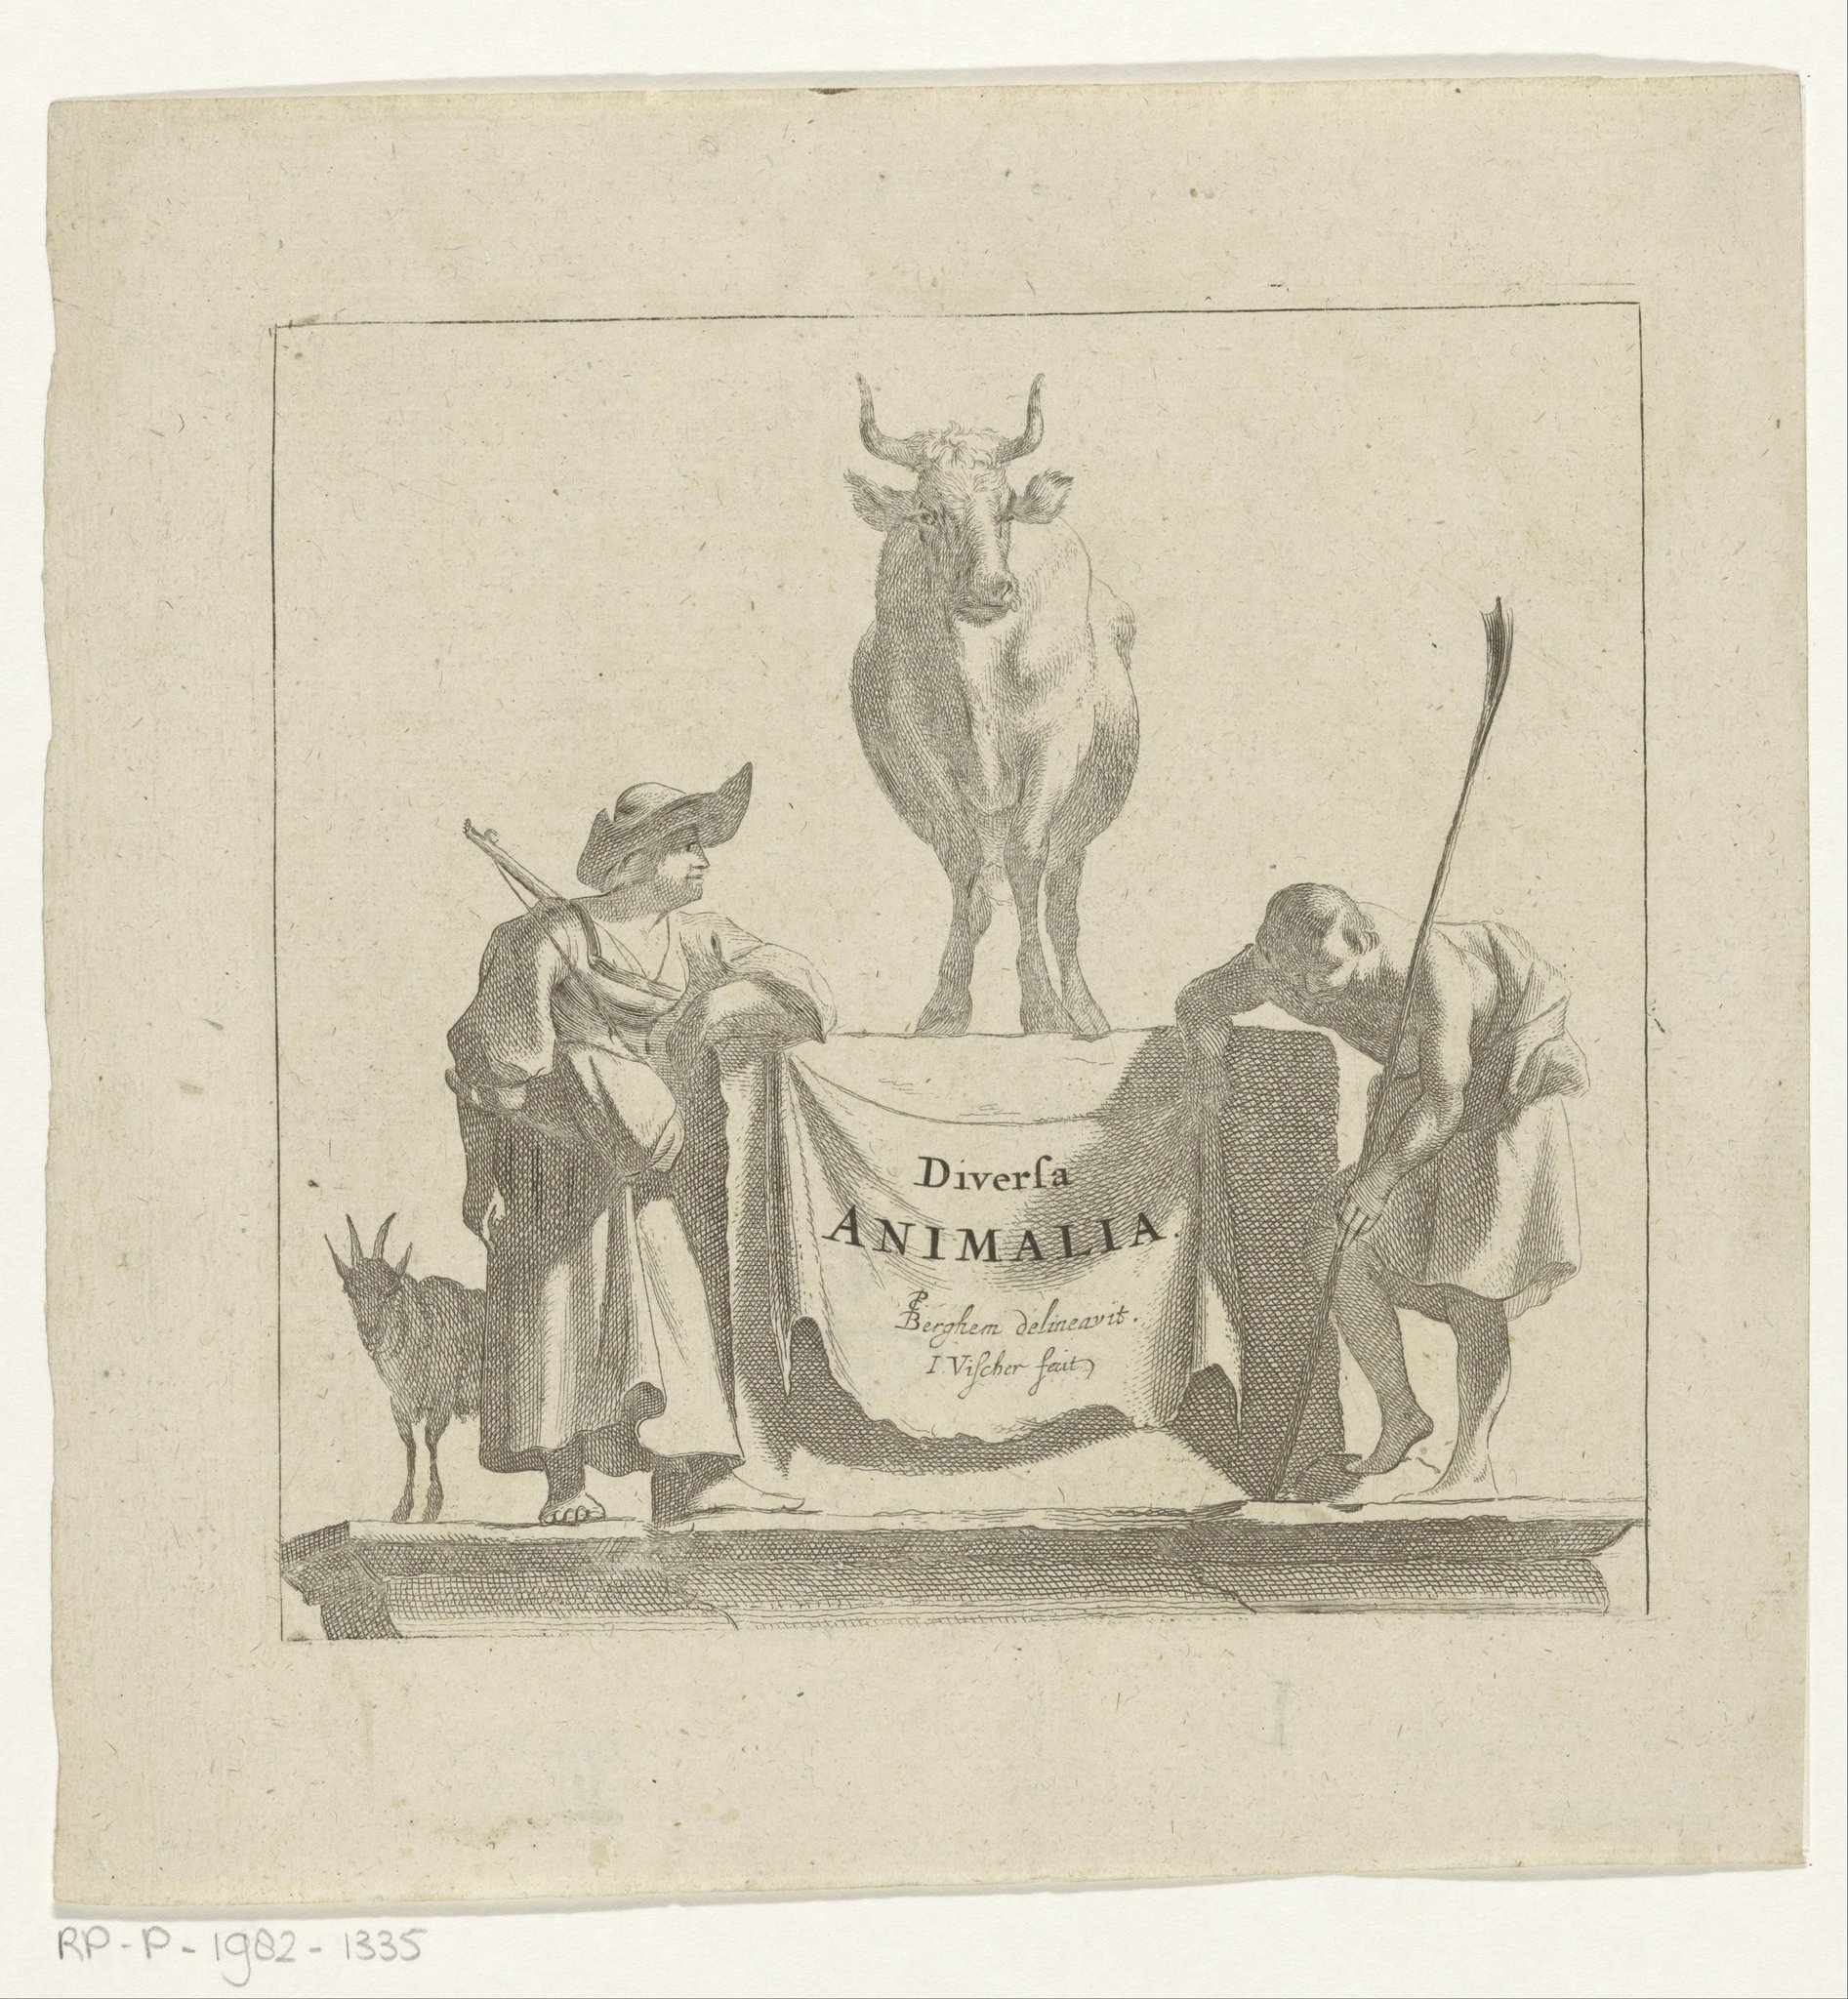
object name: titelprent, frontispice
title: Herder, herderin en koe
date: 1643-1692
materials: paper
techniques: etching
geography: northern netherlands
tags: cow, herding, herdsman, herdswoman, shepherd, shepherdess, cowherd, etc.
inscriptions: collector's mark: Lugt 1731, collector's mark: Lugt 1701, collector's mark: Lugt 2760, collector's mark: Lugt 2228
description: Titelprent voor de 12-delige serie 'Diversa Animalia' met prenten van verschillende dieren in landschappen.